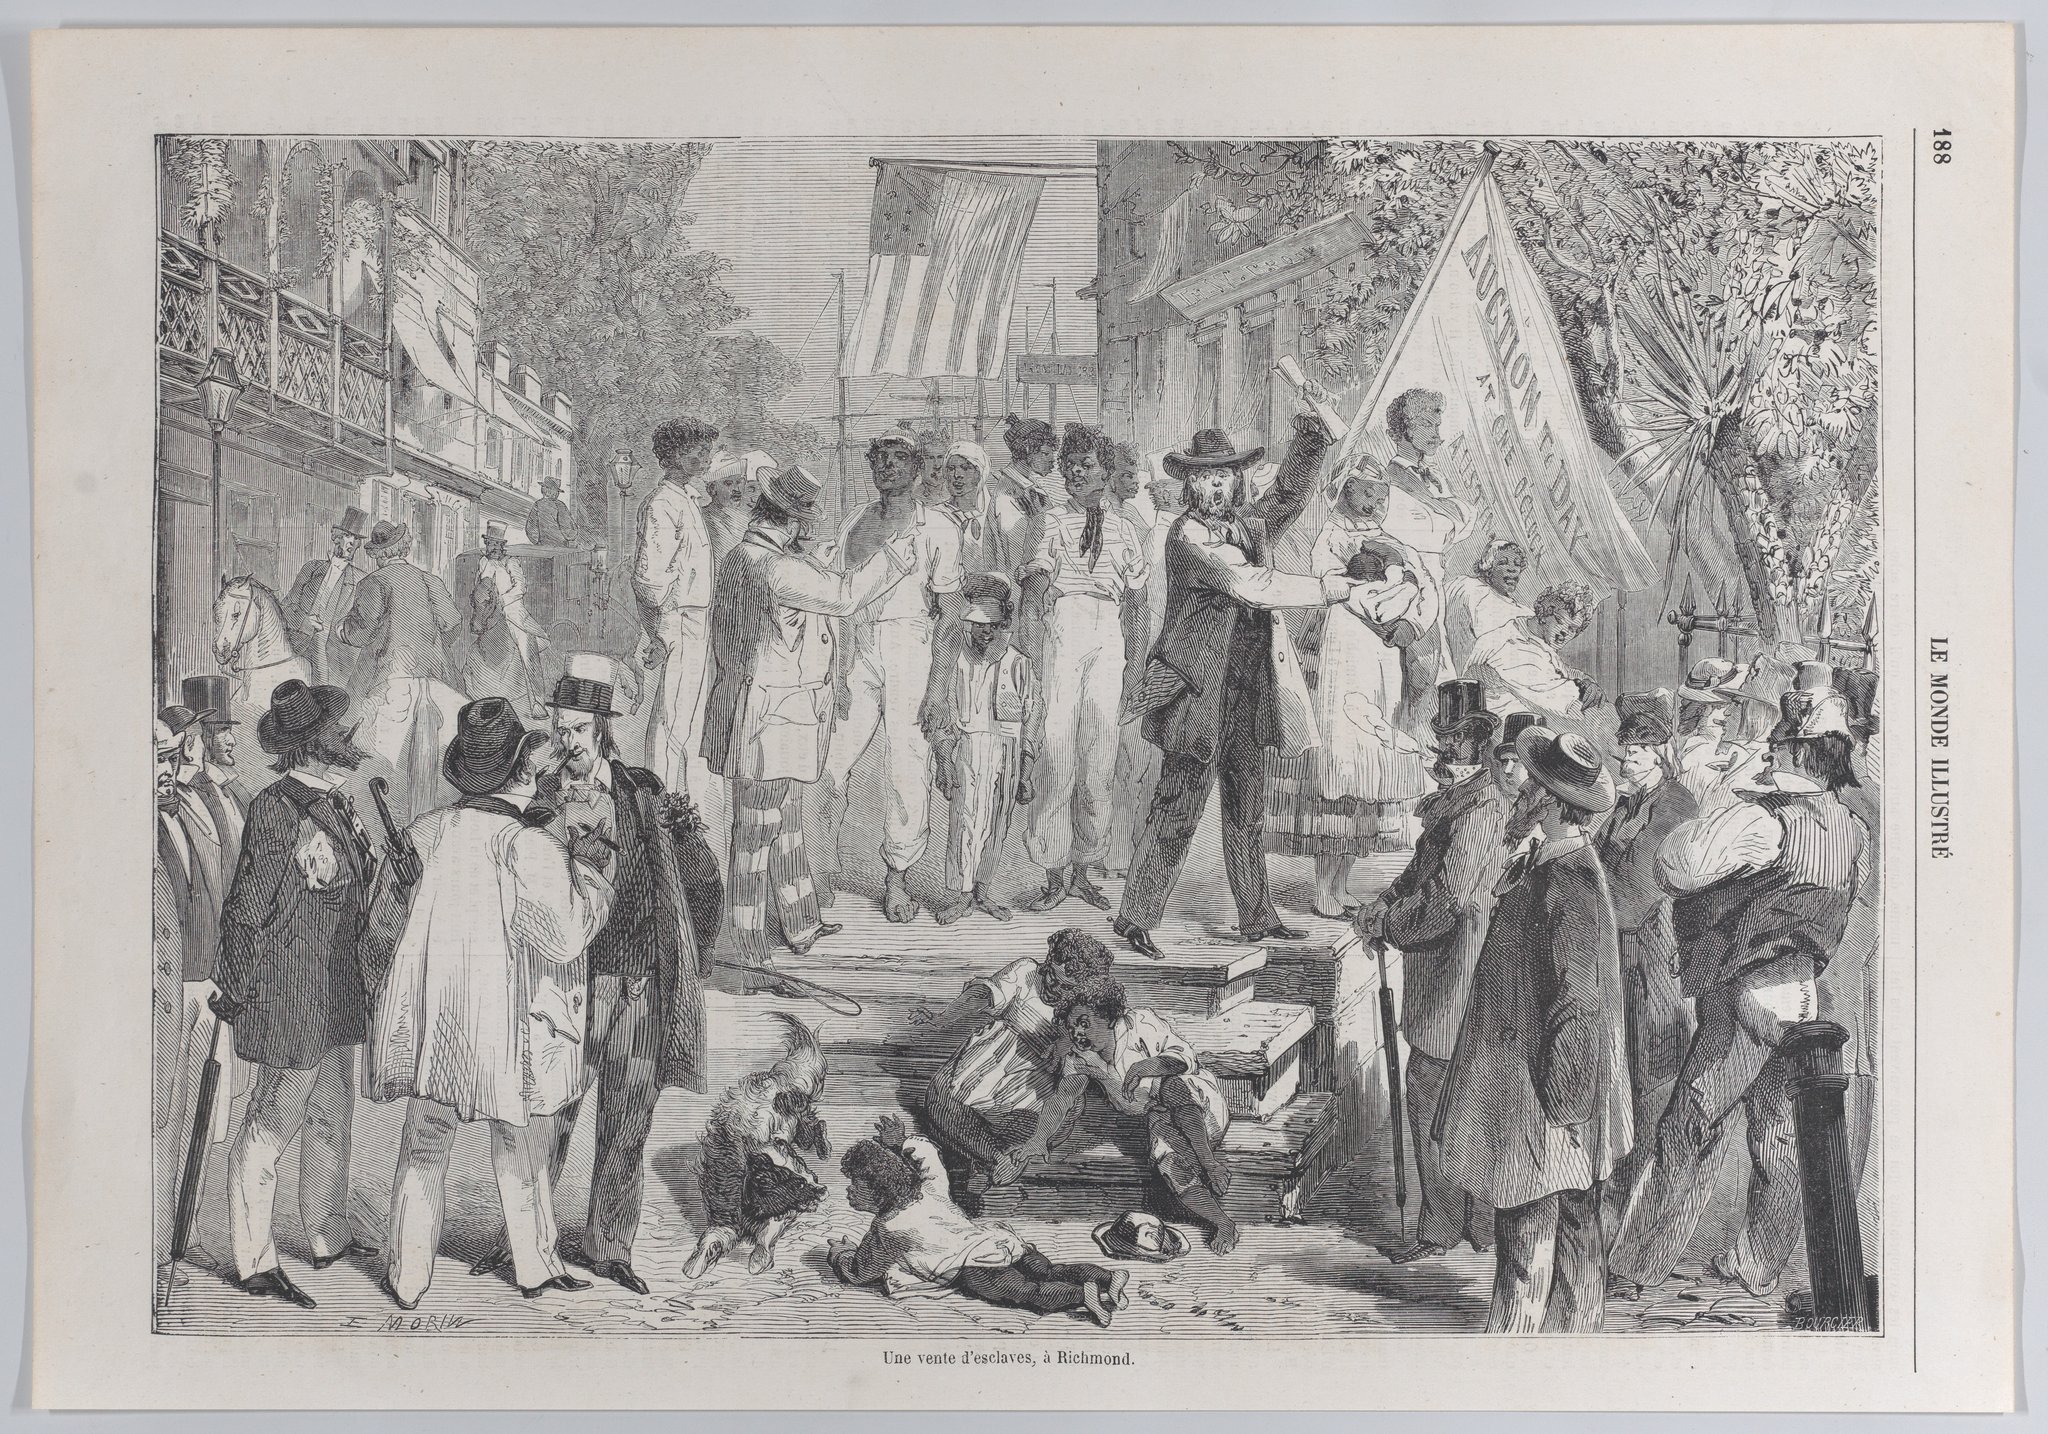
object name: print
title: An Auction of Enslaved People in Richmond, from "Le Monde Illustré"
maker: bourcier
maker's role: engraver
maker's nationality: french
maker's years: 1861-1869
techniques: engraving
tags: children,men,women,dogs,slaves